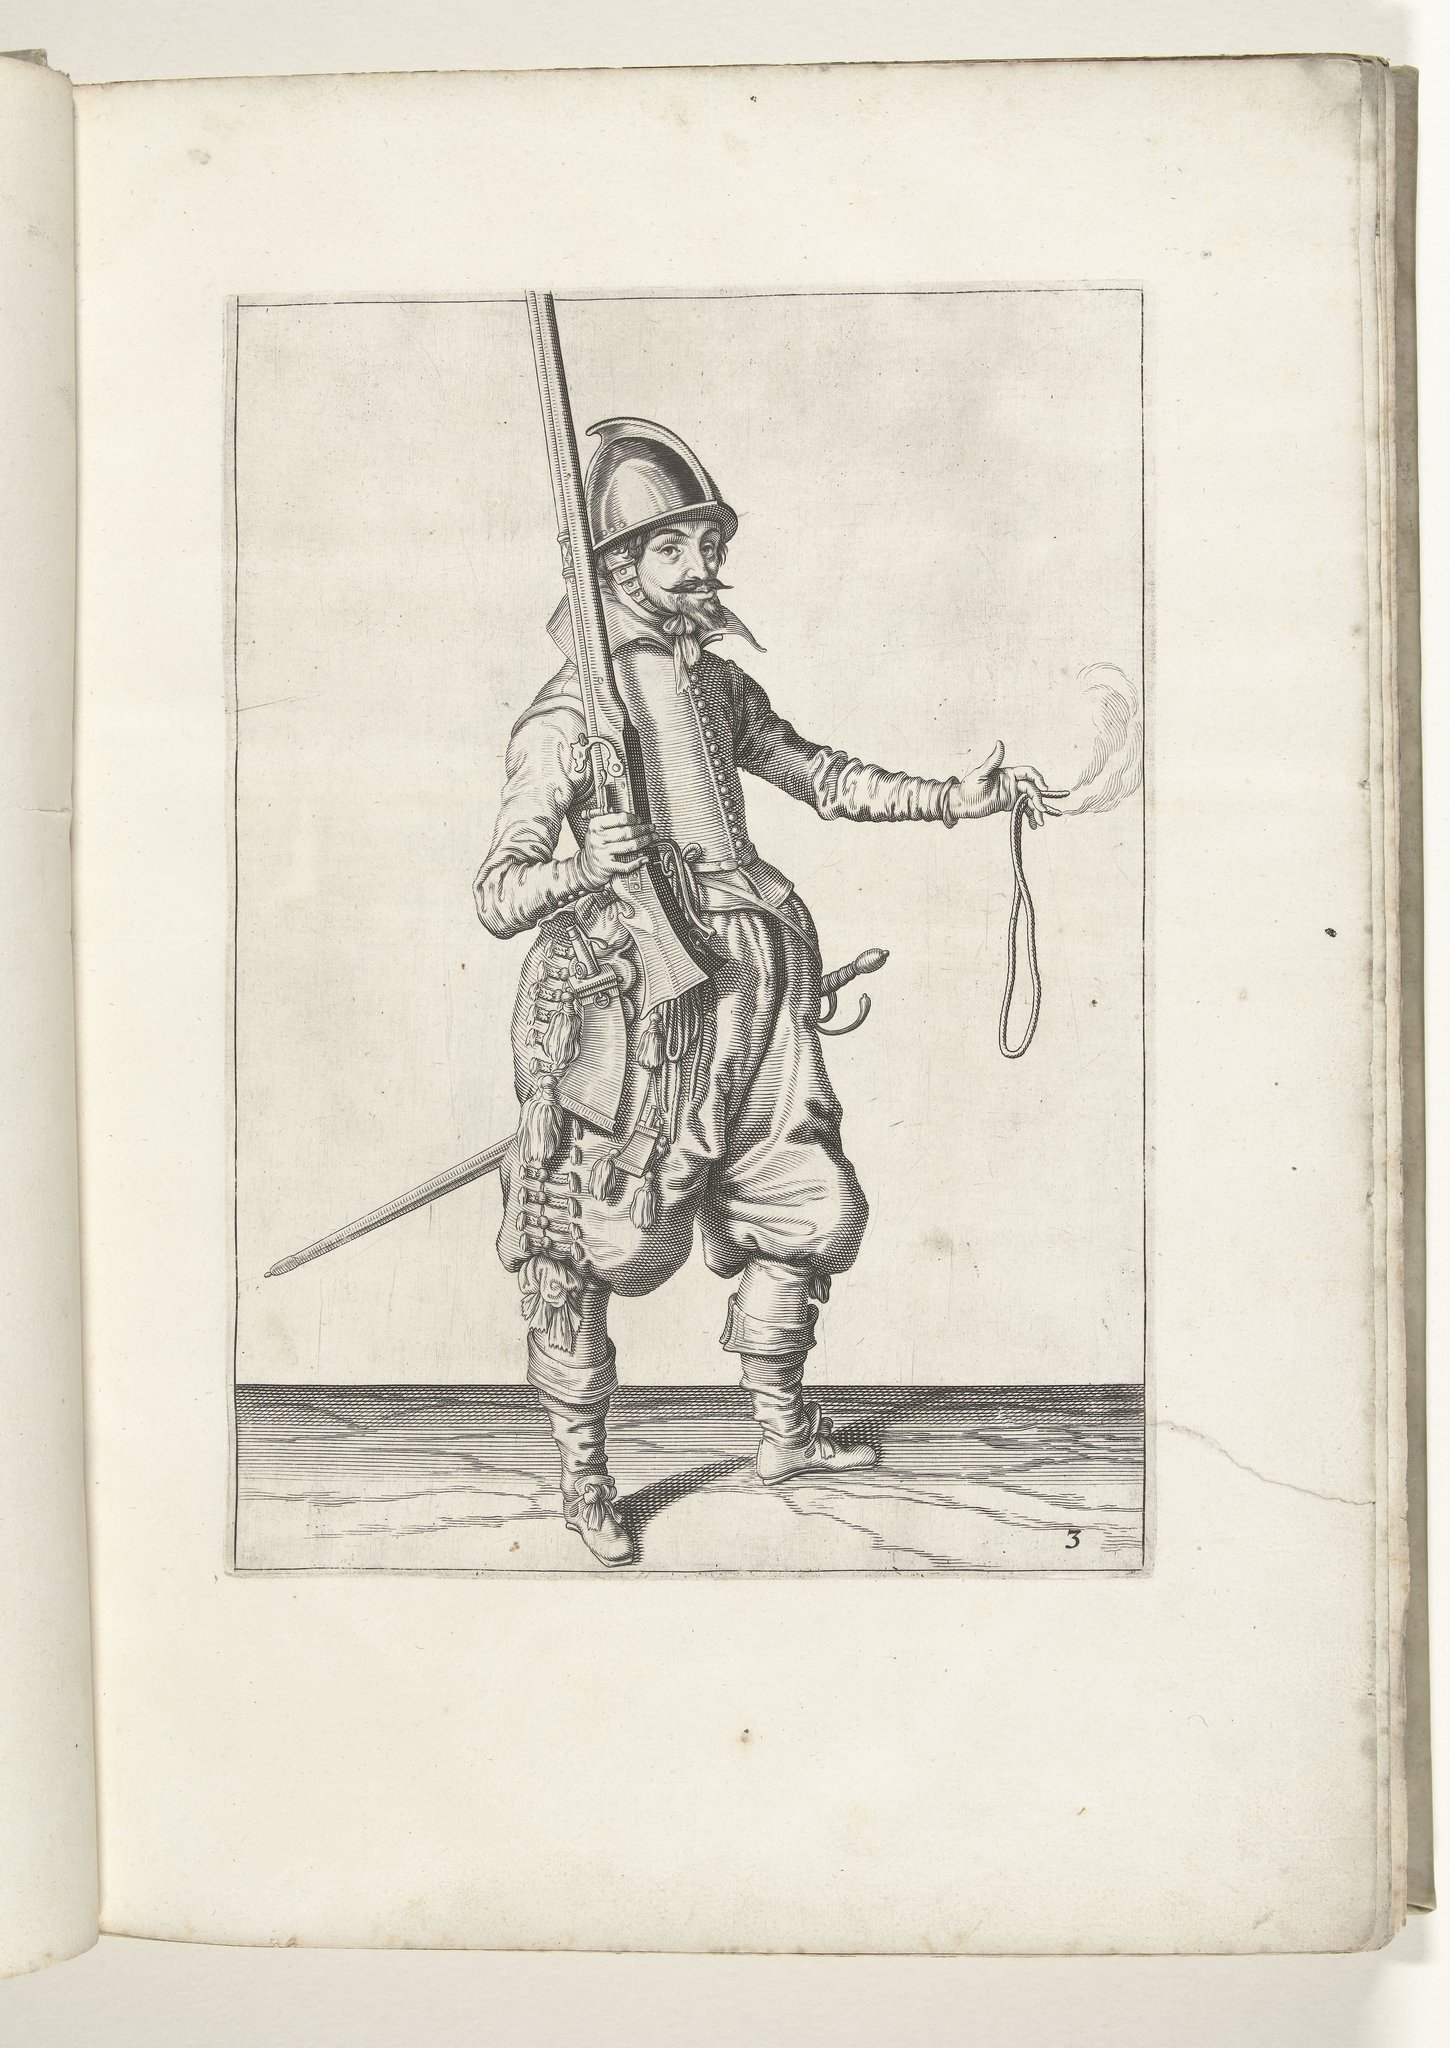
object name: print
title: Soldaat die zijn roer met zijn rechterhand rechtop vasthoudt, zijn linkerhand open om het wapen aan te nemen (nr. 3), ca. 1600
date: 1597-1607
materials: paper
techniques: engraving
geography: northern netherlands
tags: maurice (prince of orange), handling of weapons ~ military training, weapons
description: Een soldaat, ten voeten uit, naar rechts, die een roer (een bepaald type vuurwapen) met zijn rechterhand vasthoudt, de loop omhoog wijzend, alvorens zijn wapen over te brengen naar zijn linkerhand (nr. 3), ca. 1600. In zijn uitgestoken linkerhand een brandende lont. Plaat 3 in de instructies voor het hanteren van de roer: Corte onderwysinghe op de figuerliicke afbeeldinghe, belanghende t'rechte ghebruyck des Roers. Onderdeel van de illustraties in: J. de Gheyn, Wapenhandelinghe van Roers Musquetten ende spiessen, 's-Gravenhage, 1607. Krijgswezen rond 1600.